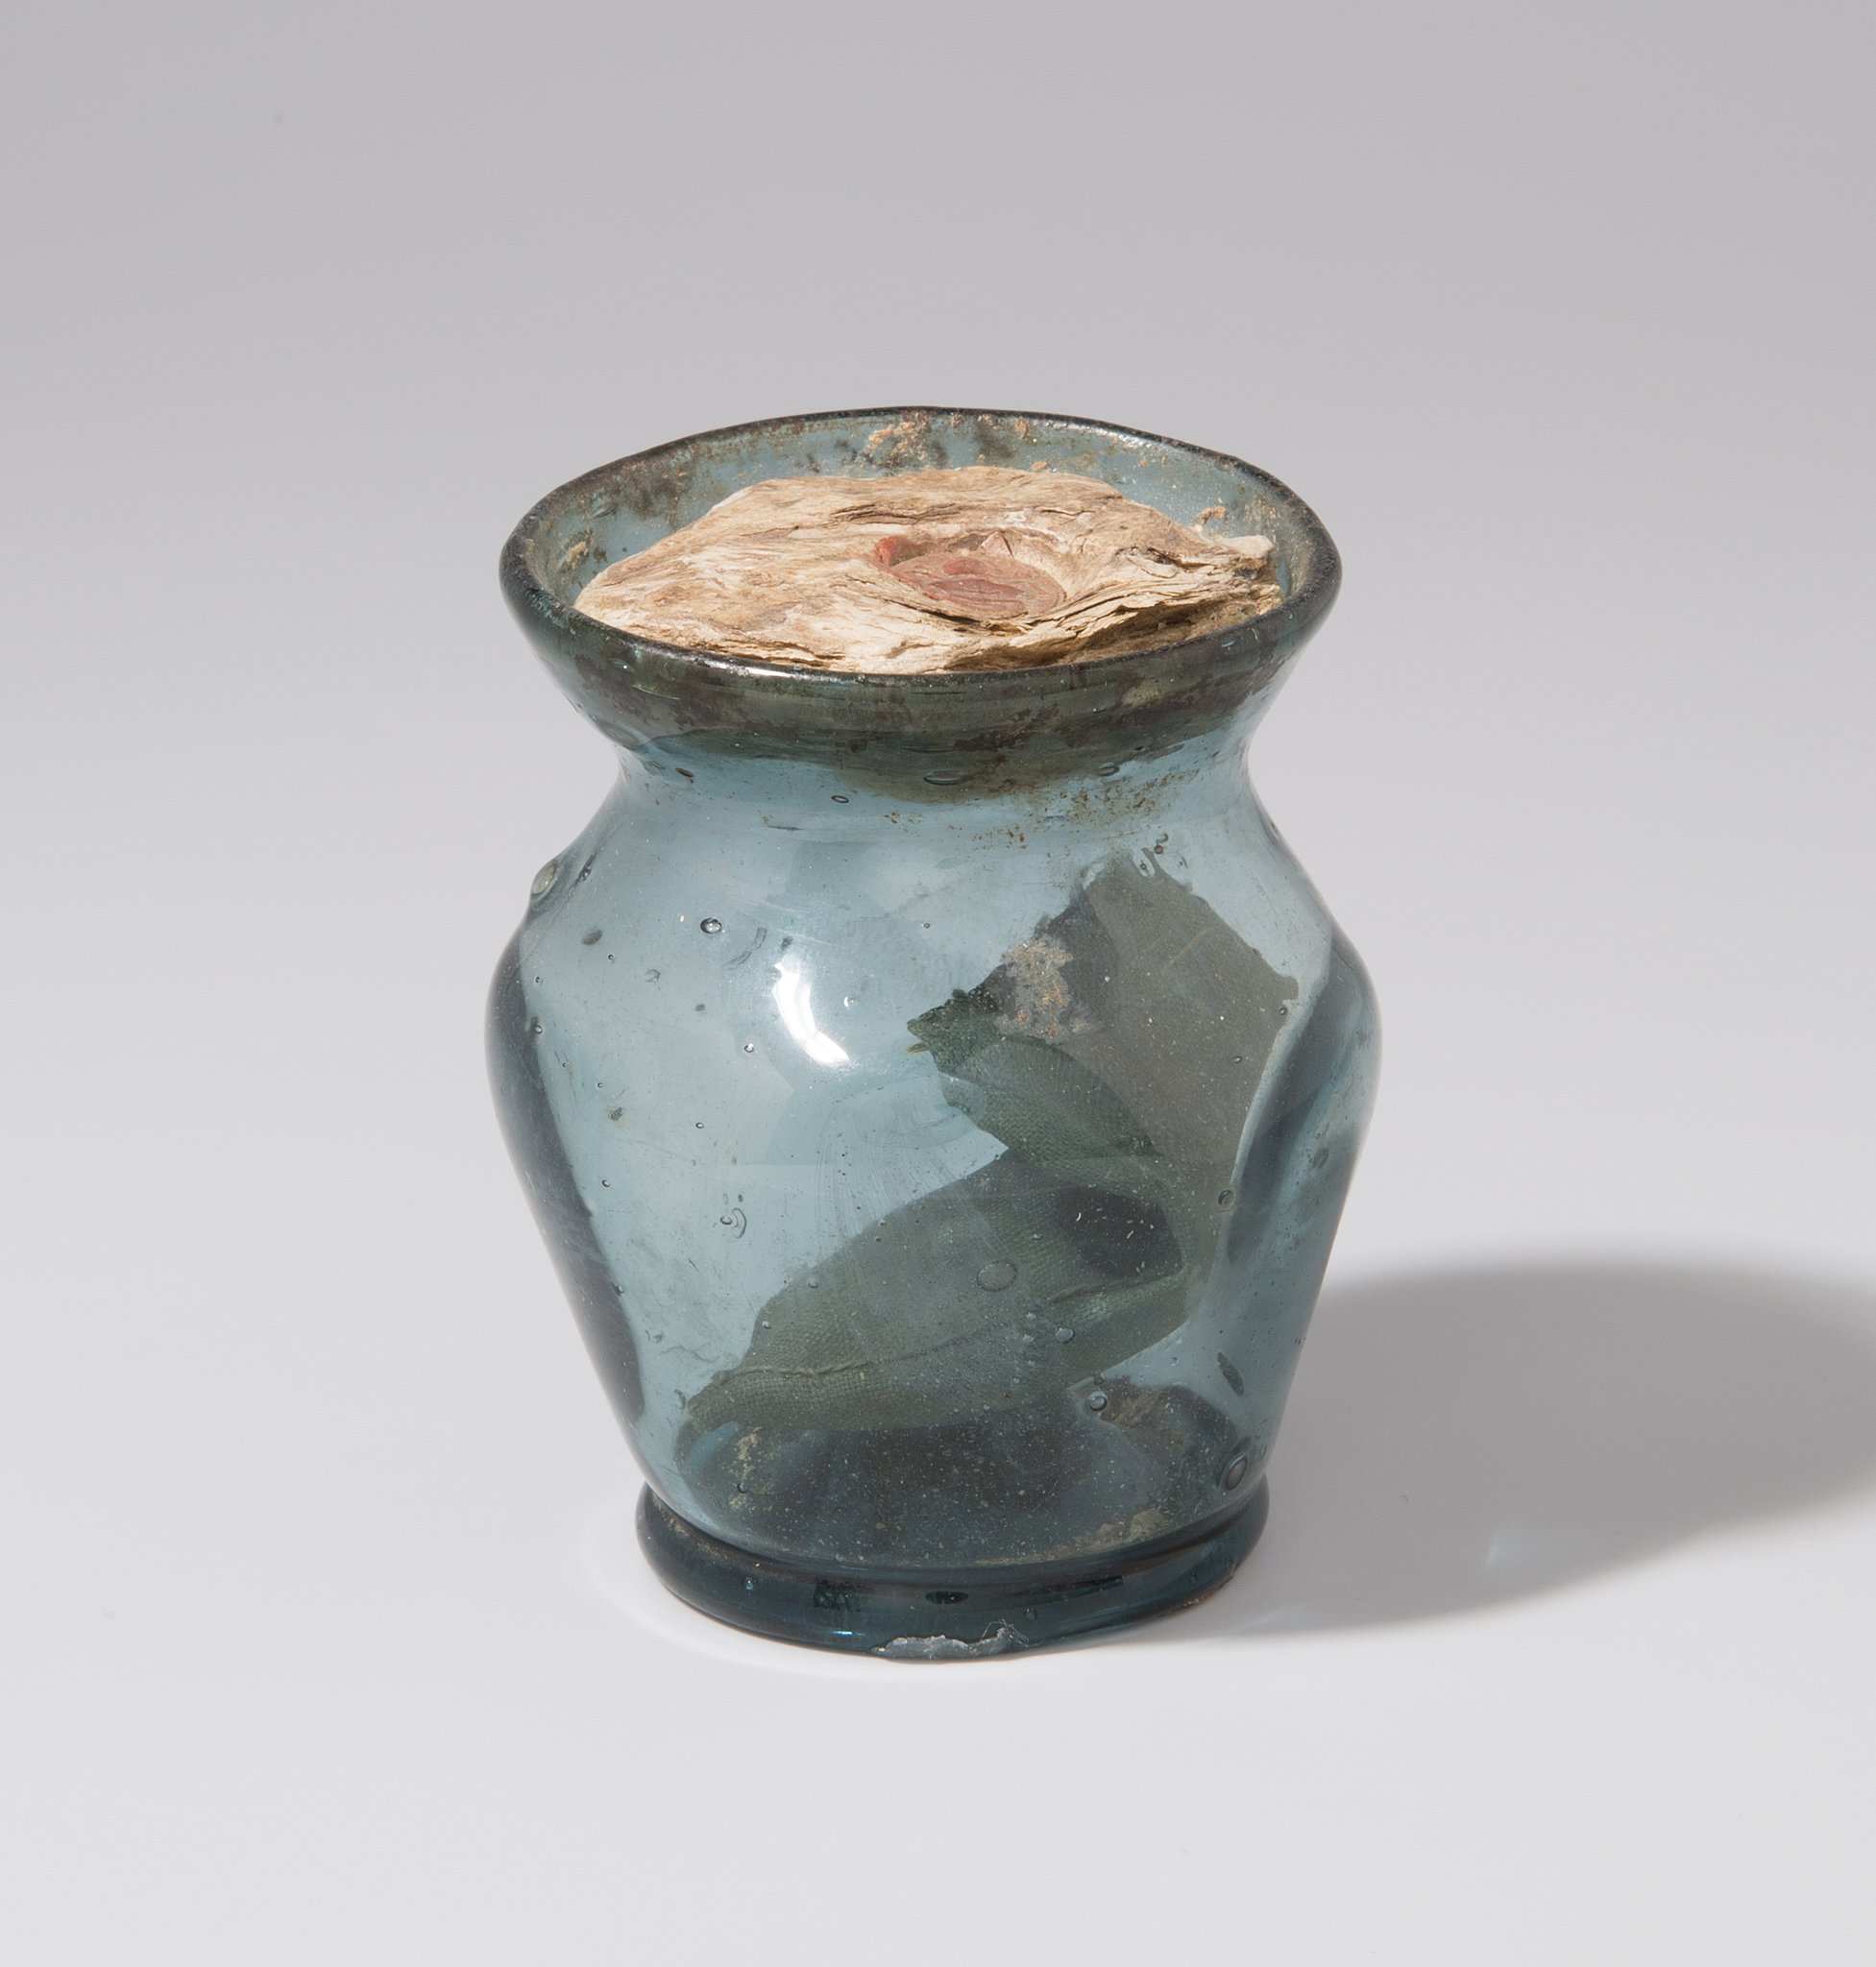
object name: reliquary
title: Glass Reliquary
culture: dutch or german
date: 1467-1533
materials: leather, silk, wax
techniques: glassblowing